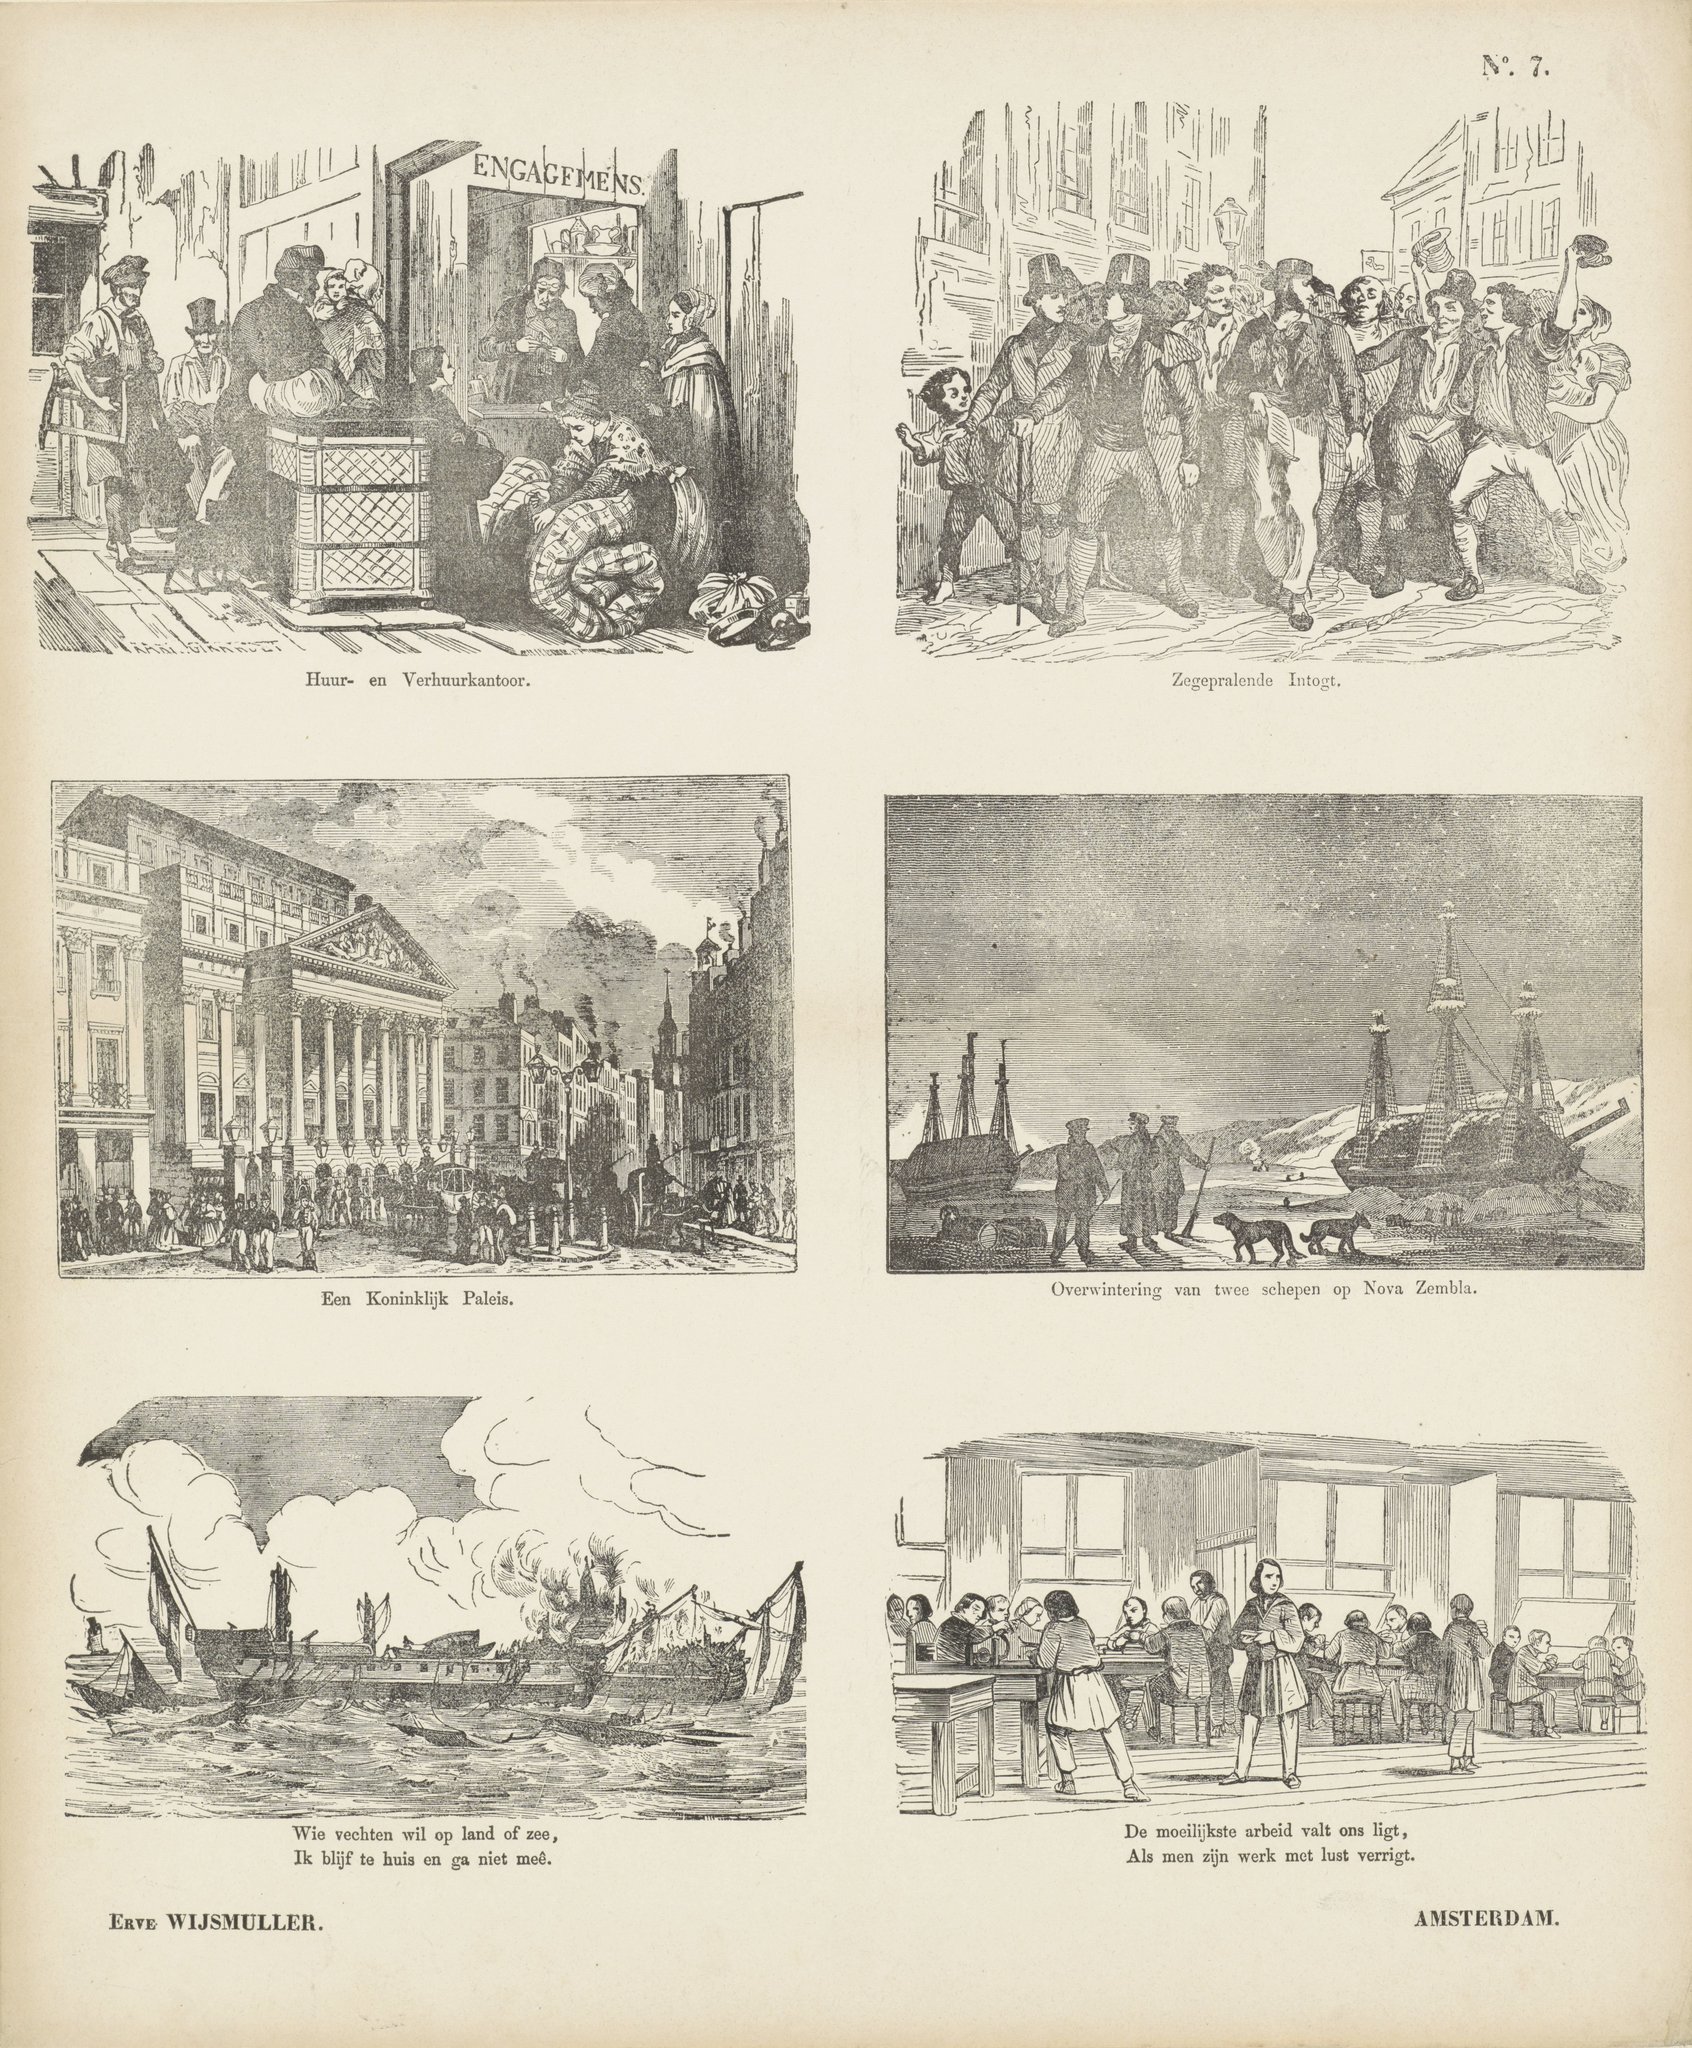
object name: popular print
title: Verschillende voorstellingen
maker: Anonymous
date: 1828-1913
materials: paper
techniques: letterpress printing, line block, engraving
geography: netherlands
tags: ships (in general), office (~ administration), royal palace of amsterdam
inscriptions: collector's mark: Lugt 2760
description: Blad met 6 voorstellingen van verschillende aard, waaronder een intocht, het Paleis op de Dam, de overwintering op Nova Zembla en een gehavend schip. Onder elke afbeelding een onderschrift. Onder de eerste afbeelding het onderschrift: Huur- en verhuurkantoor. Genummerd rechtsboven: No. 7.